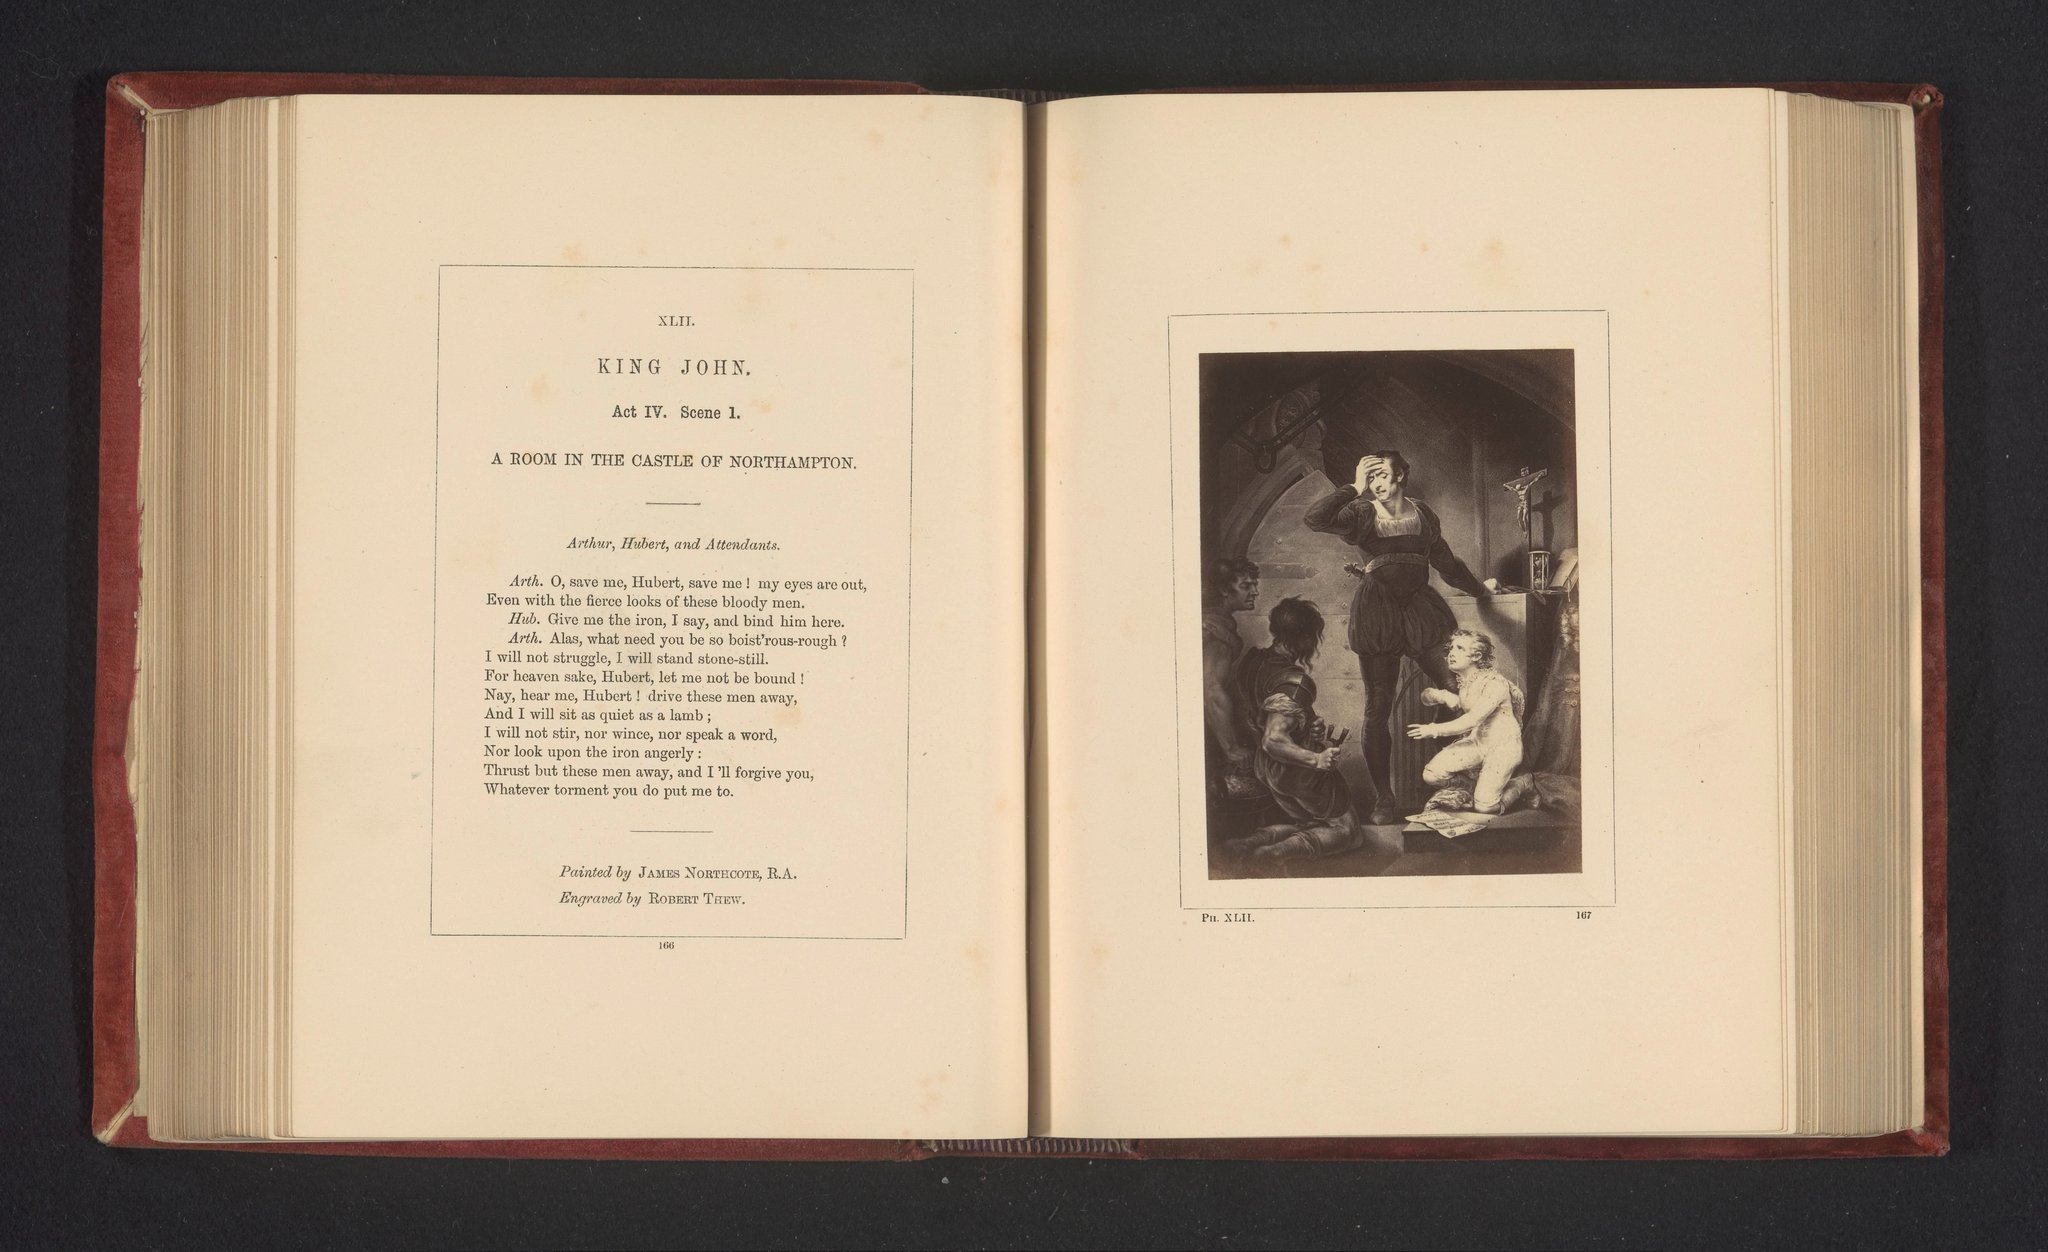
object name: page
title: Fotoreproductie van een prent naar een schilderij door James Northcote, voorstellend een scene uit Koning Jan door William Shakespeare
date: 1854-1864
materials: photographic support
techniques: albumen print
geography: london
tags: specific works of literature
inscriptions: number: ‘Ph. XLII. 167’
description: Te zien is akte IV, scene 1 met Arthur I, de hertog van Bretagne en Hubert de Burgh.